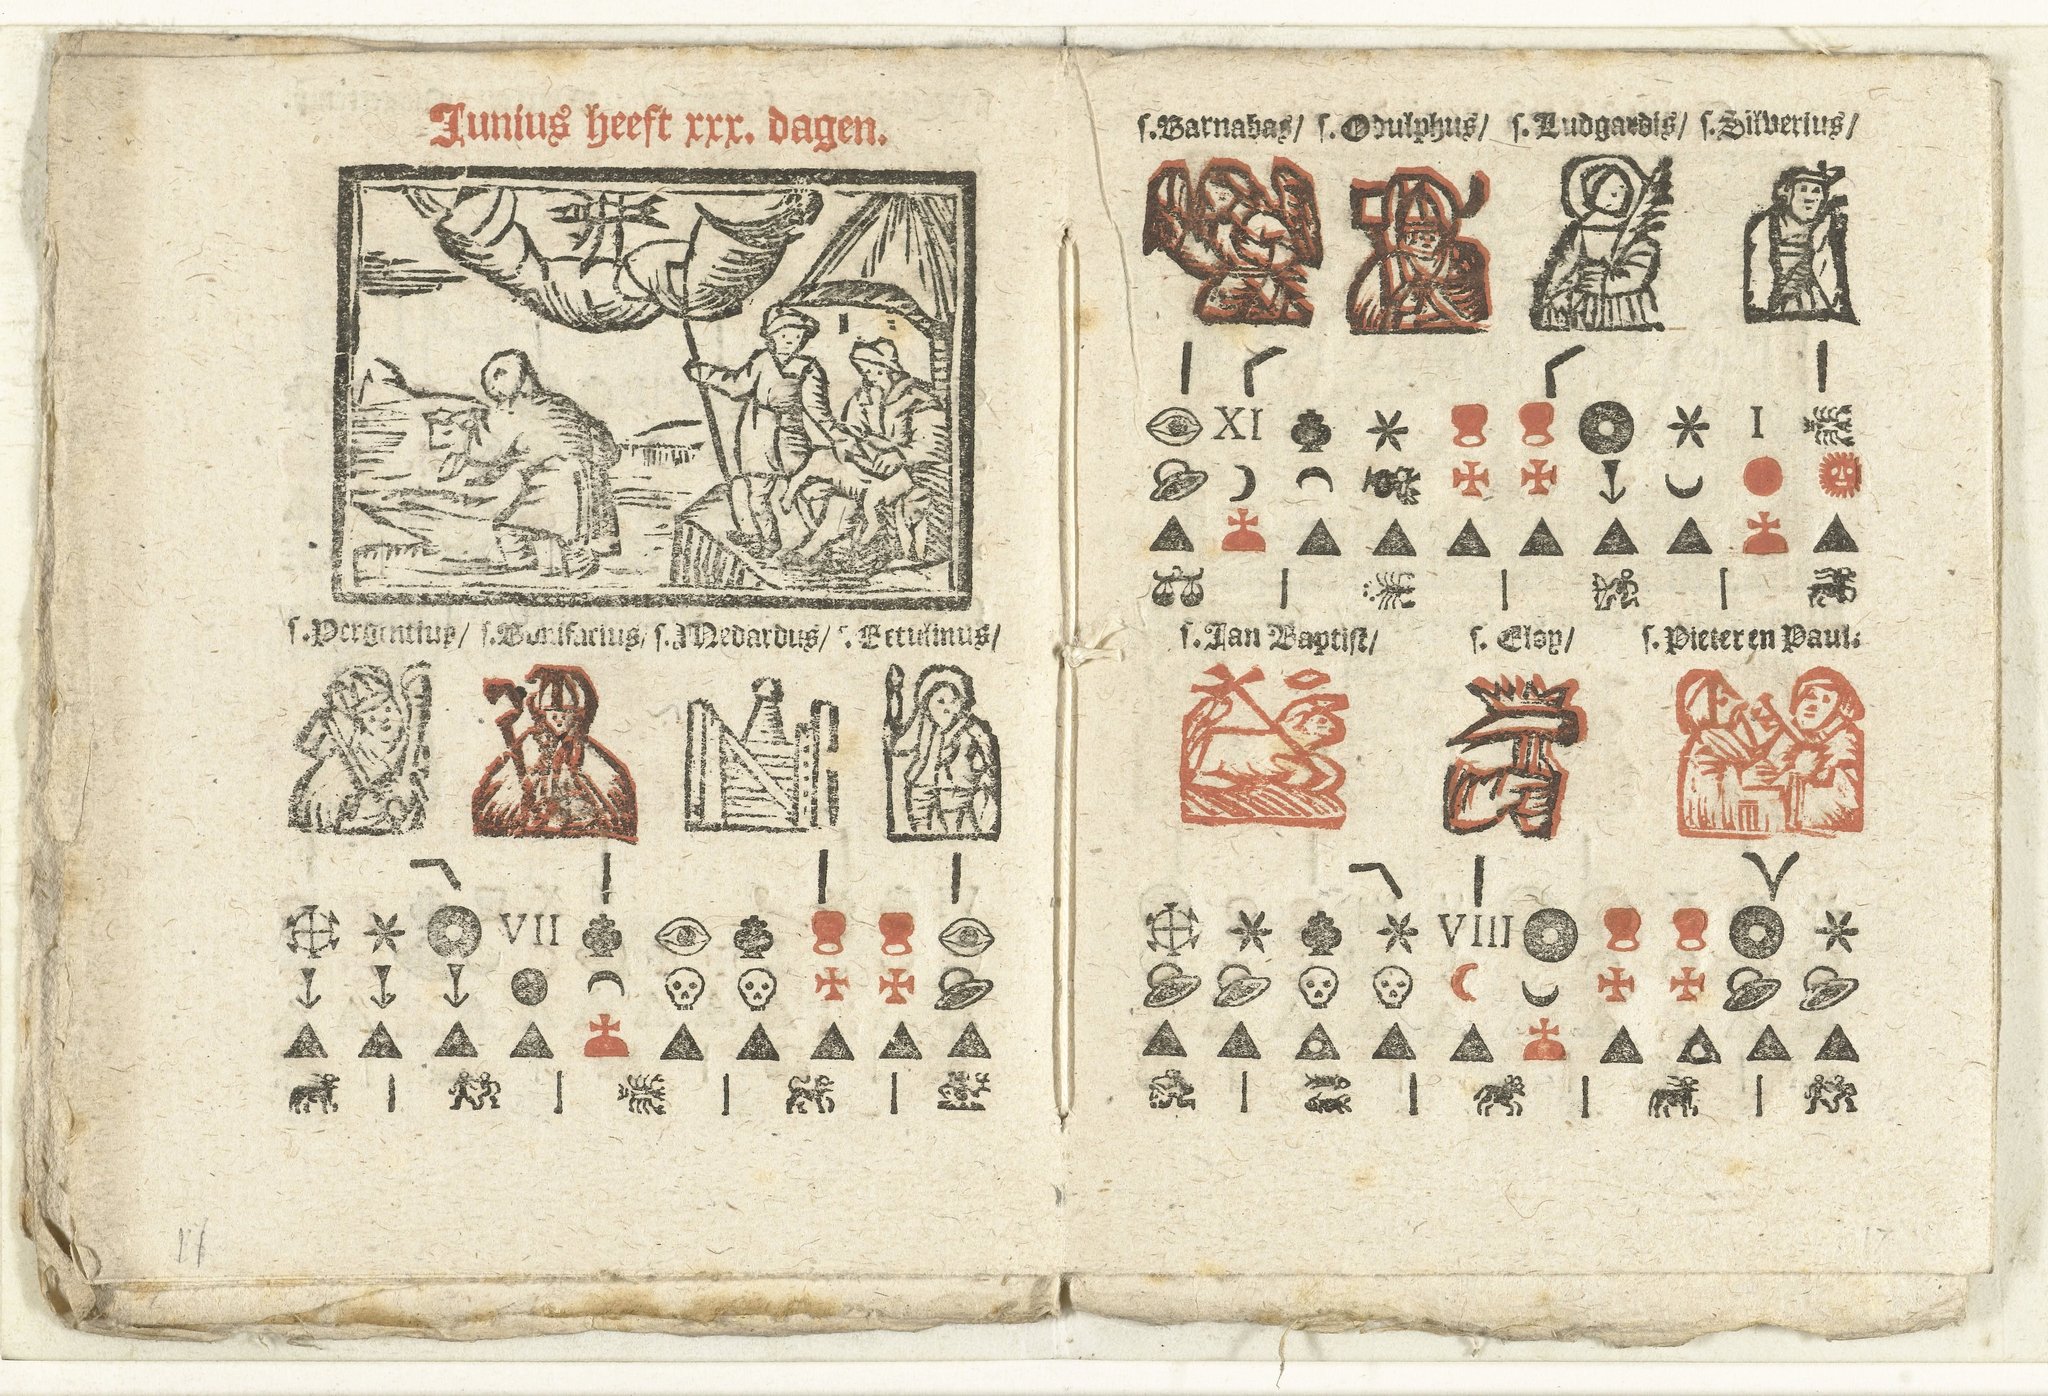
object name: print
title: Bladzijden met de voorspelling voor de maand juni, 1712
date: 1712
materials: paper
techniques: letterpress printing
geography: southern netherlands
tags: june and its 'labours' (+ with zodiacal signs)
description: Bladzijden in: Den Boeren / Oft Schapers Almanach Voor 't Schrickel Jaer ins Heeren Jesu Christi, 1712. Antwerpen: bij Wed. Slegers 1712. Exemplaar in de Rijksmuseum Research Library (signatuur: 305 G 19).